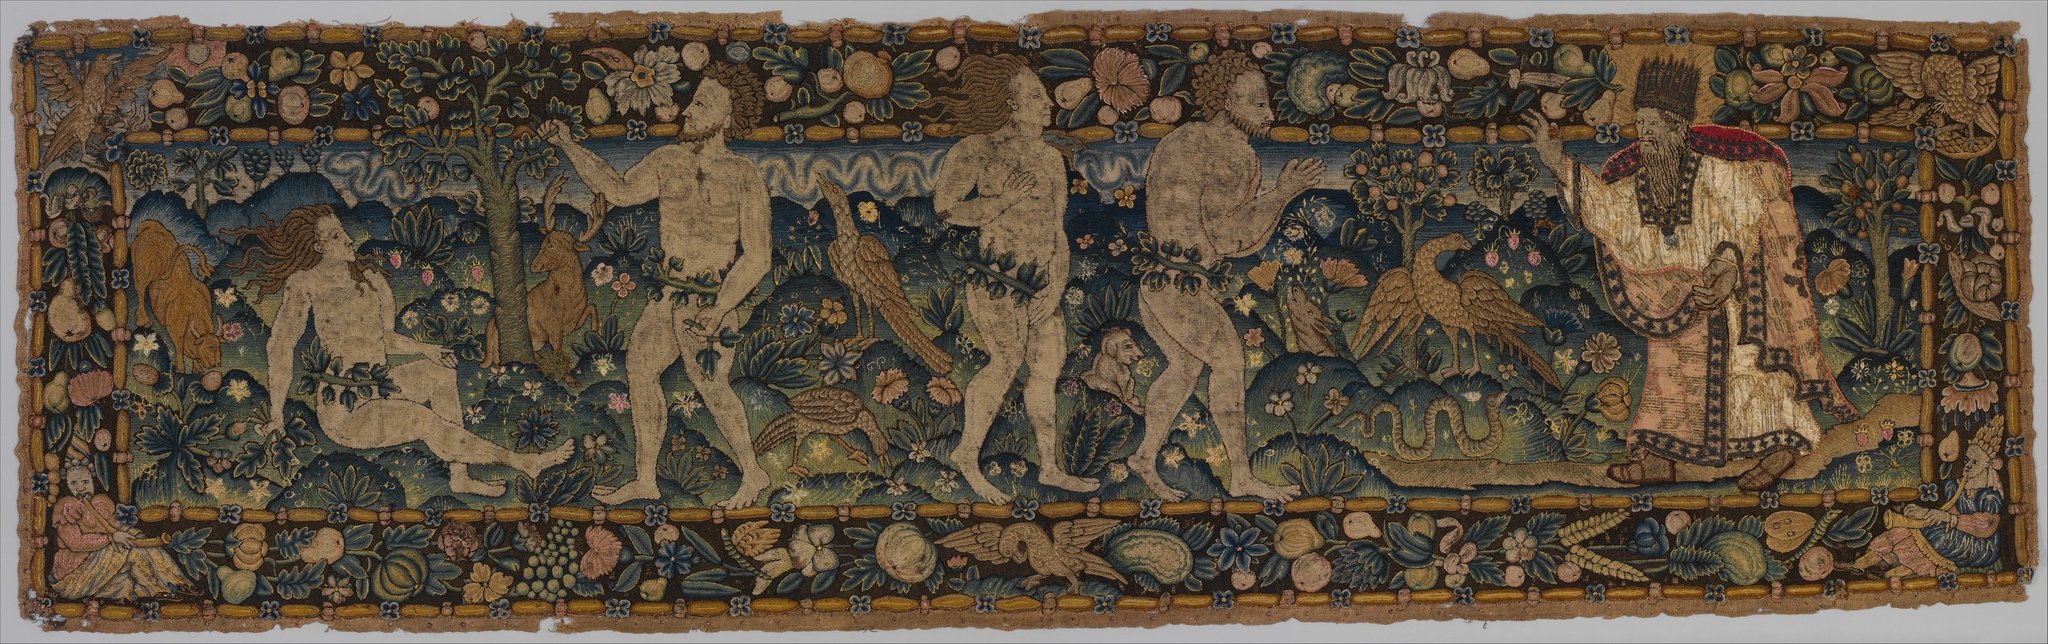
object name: bed valance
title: Adam and Eve Making Garments of Leaves; God Admonishing Adam and Eve for their Transgression (one of a set of three)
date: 1567-1600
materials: canvas, metal thread, silk, wool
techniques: appliqué, stitching, weave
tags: birds,snakes,adam,eve,ox,god the father